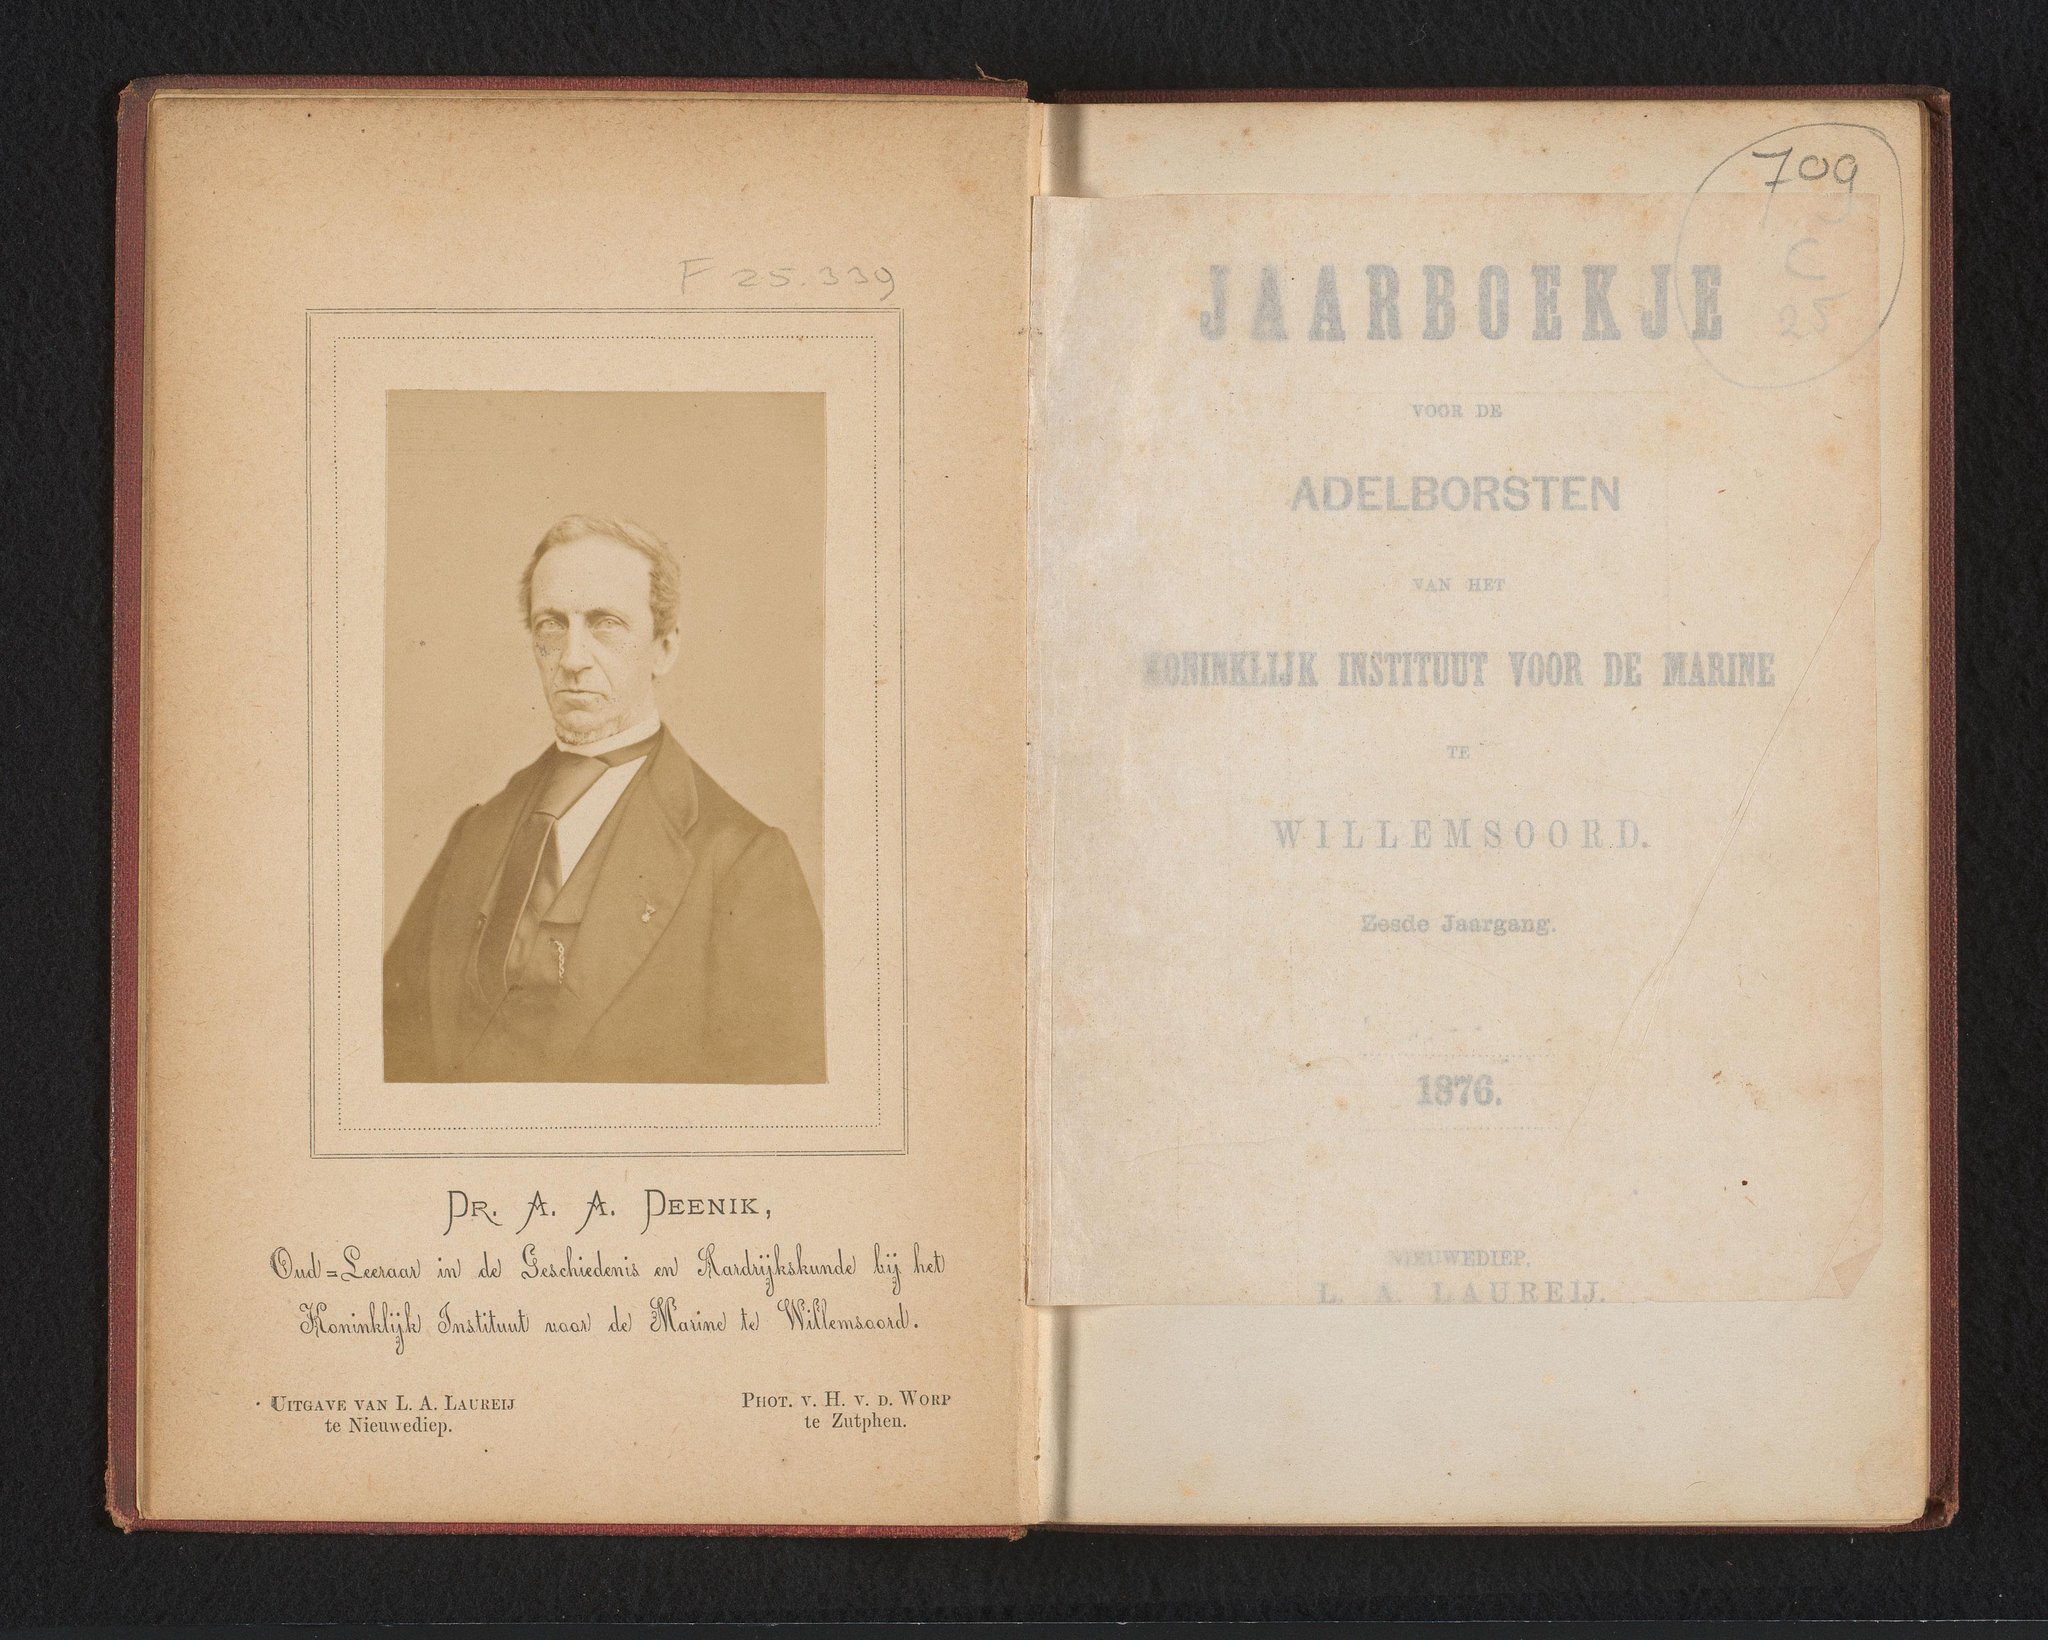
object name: page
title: Portret van A.A. Deenik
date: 1875-1876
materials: paper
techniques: albumen print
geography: nieuwediep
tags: historical persons